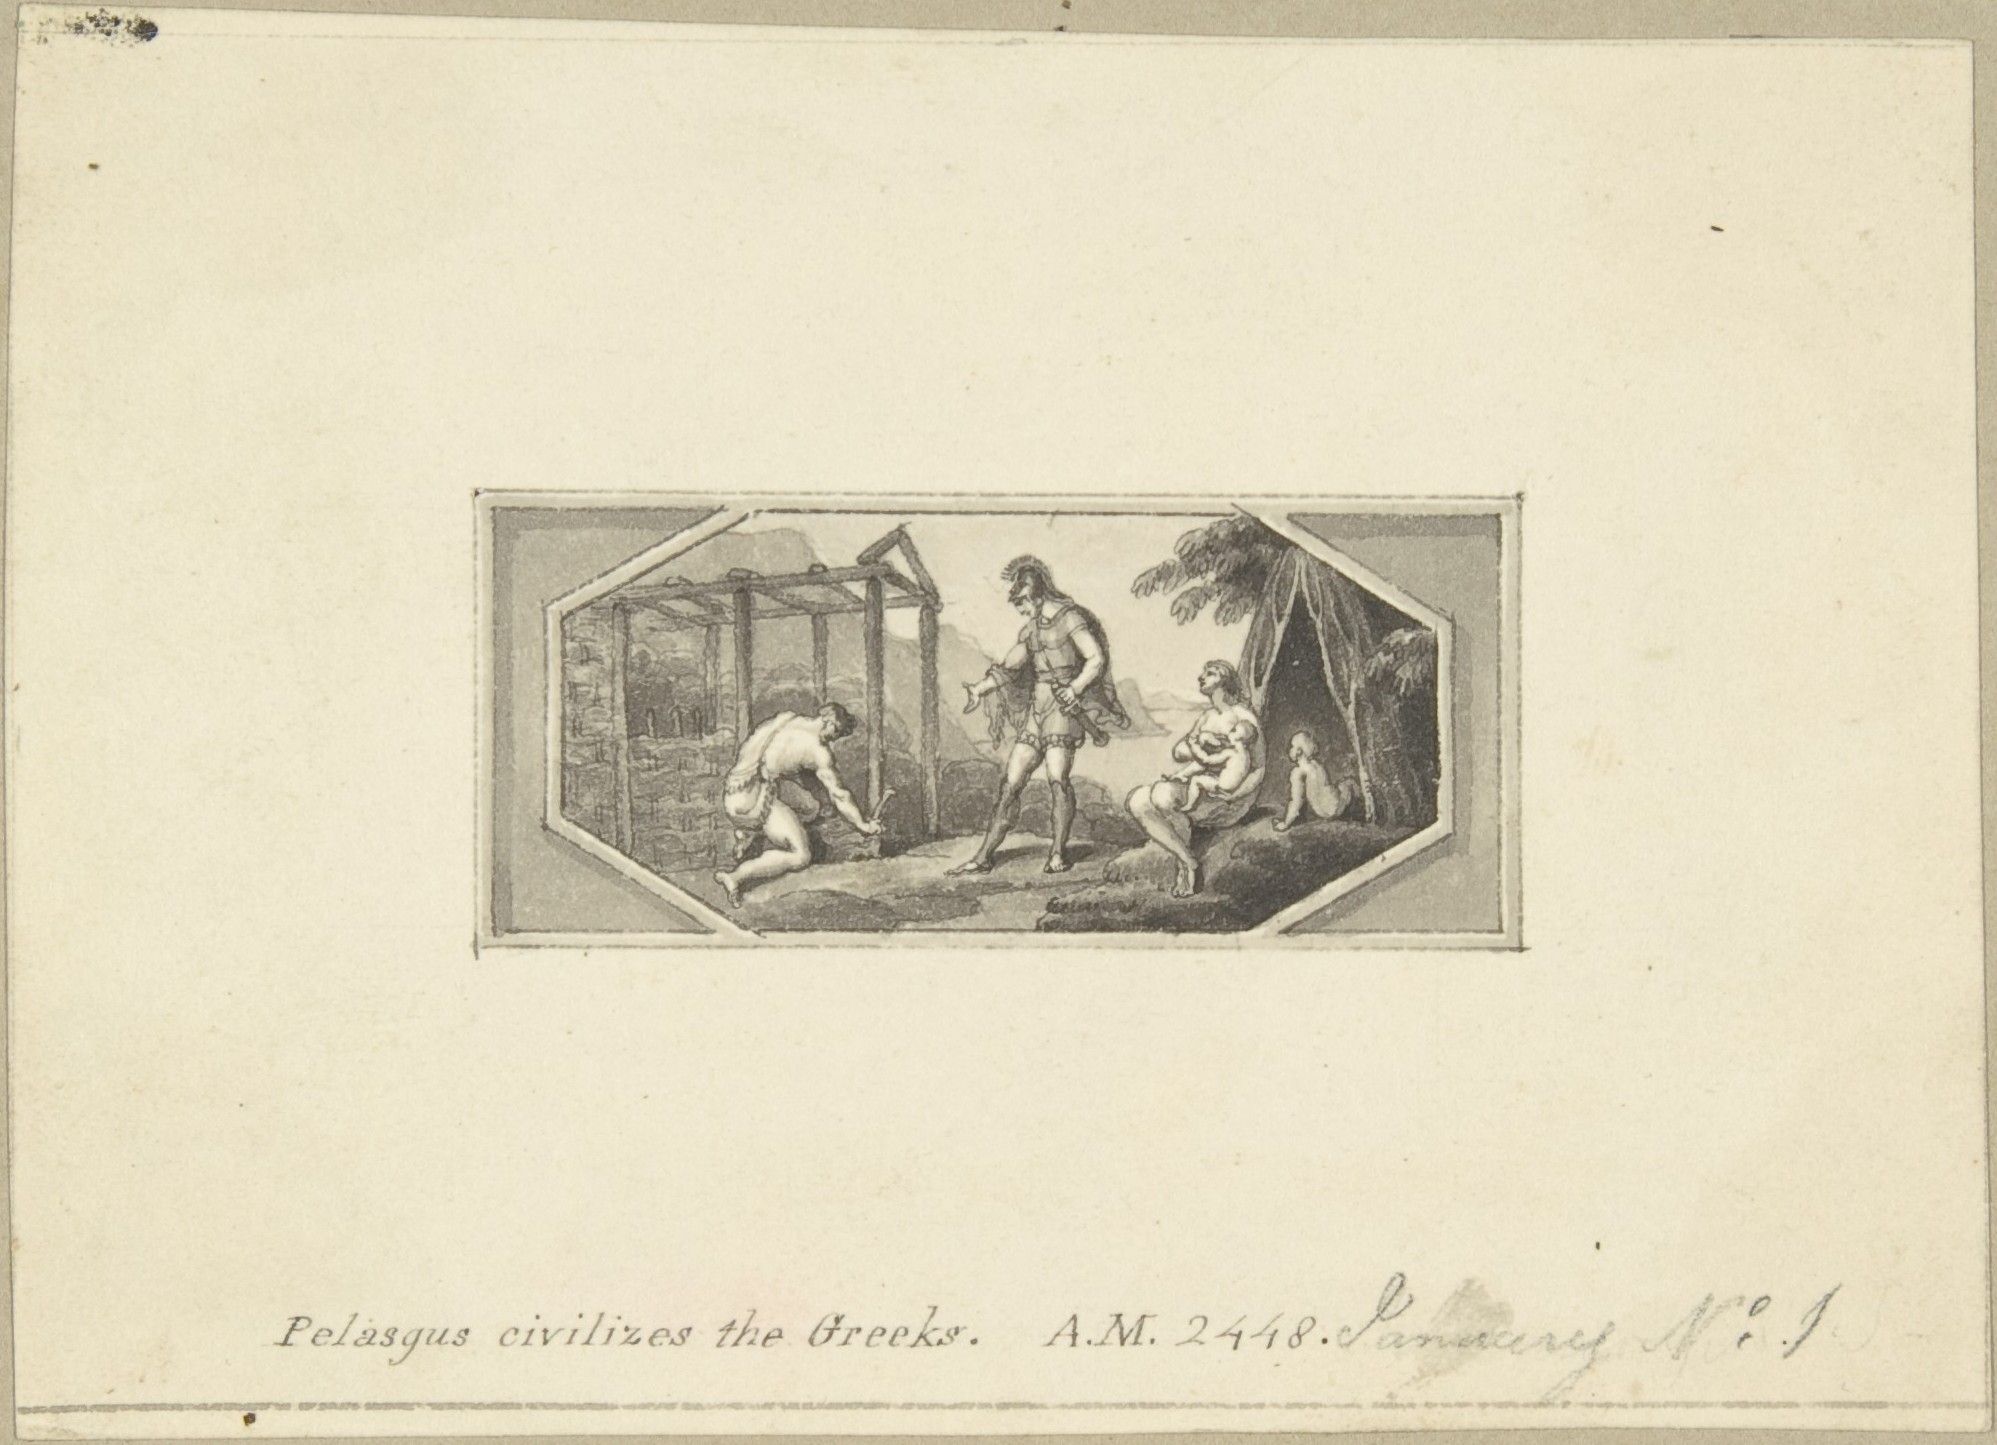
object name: drawing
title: Pelasgus Civilizes the Greeks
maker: edward francis burney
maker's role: artist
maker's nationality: british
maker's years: 1760-1848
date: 1790-1800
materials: ink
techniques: brush, pen, wash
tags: soldiers,infants,men,women,working